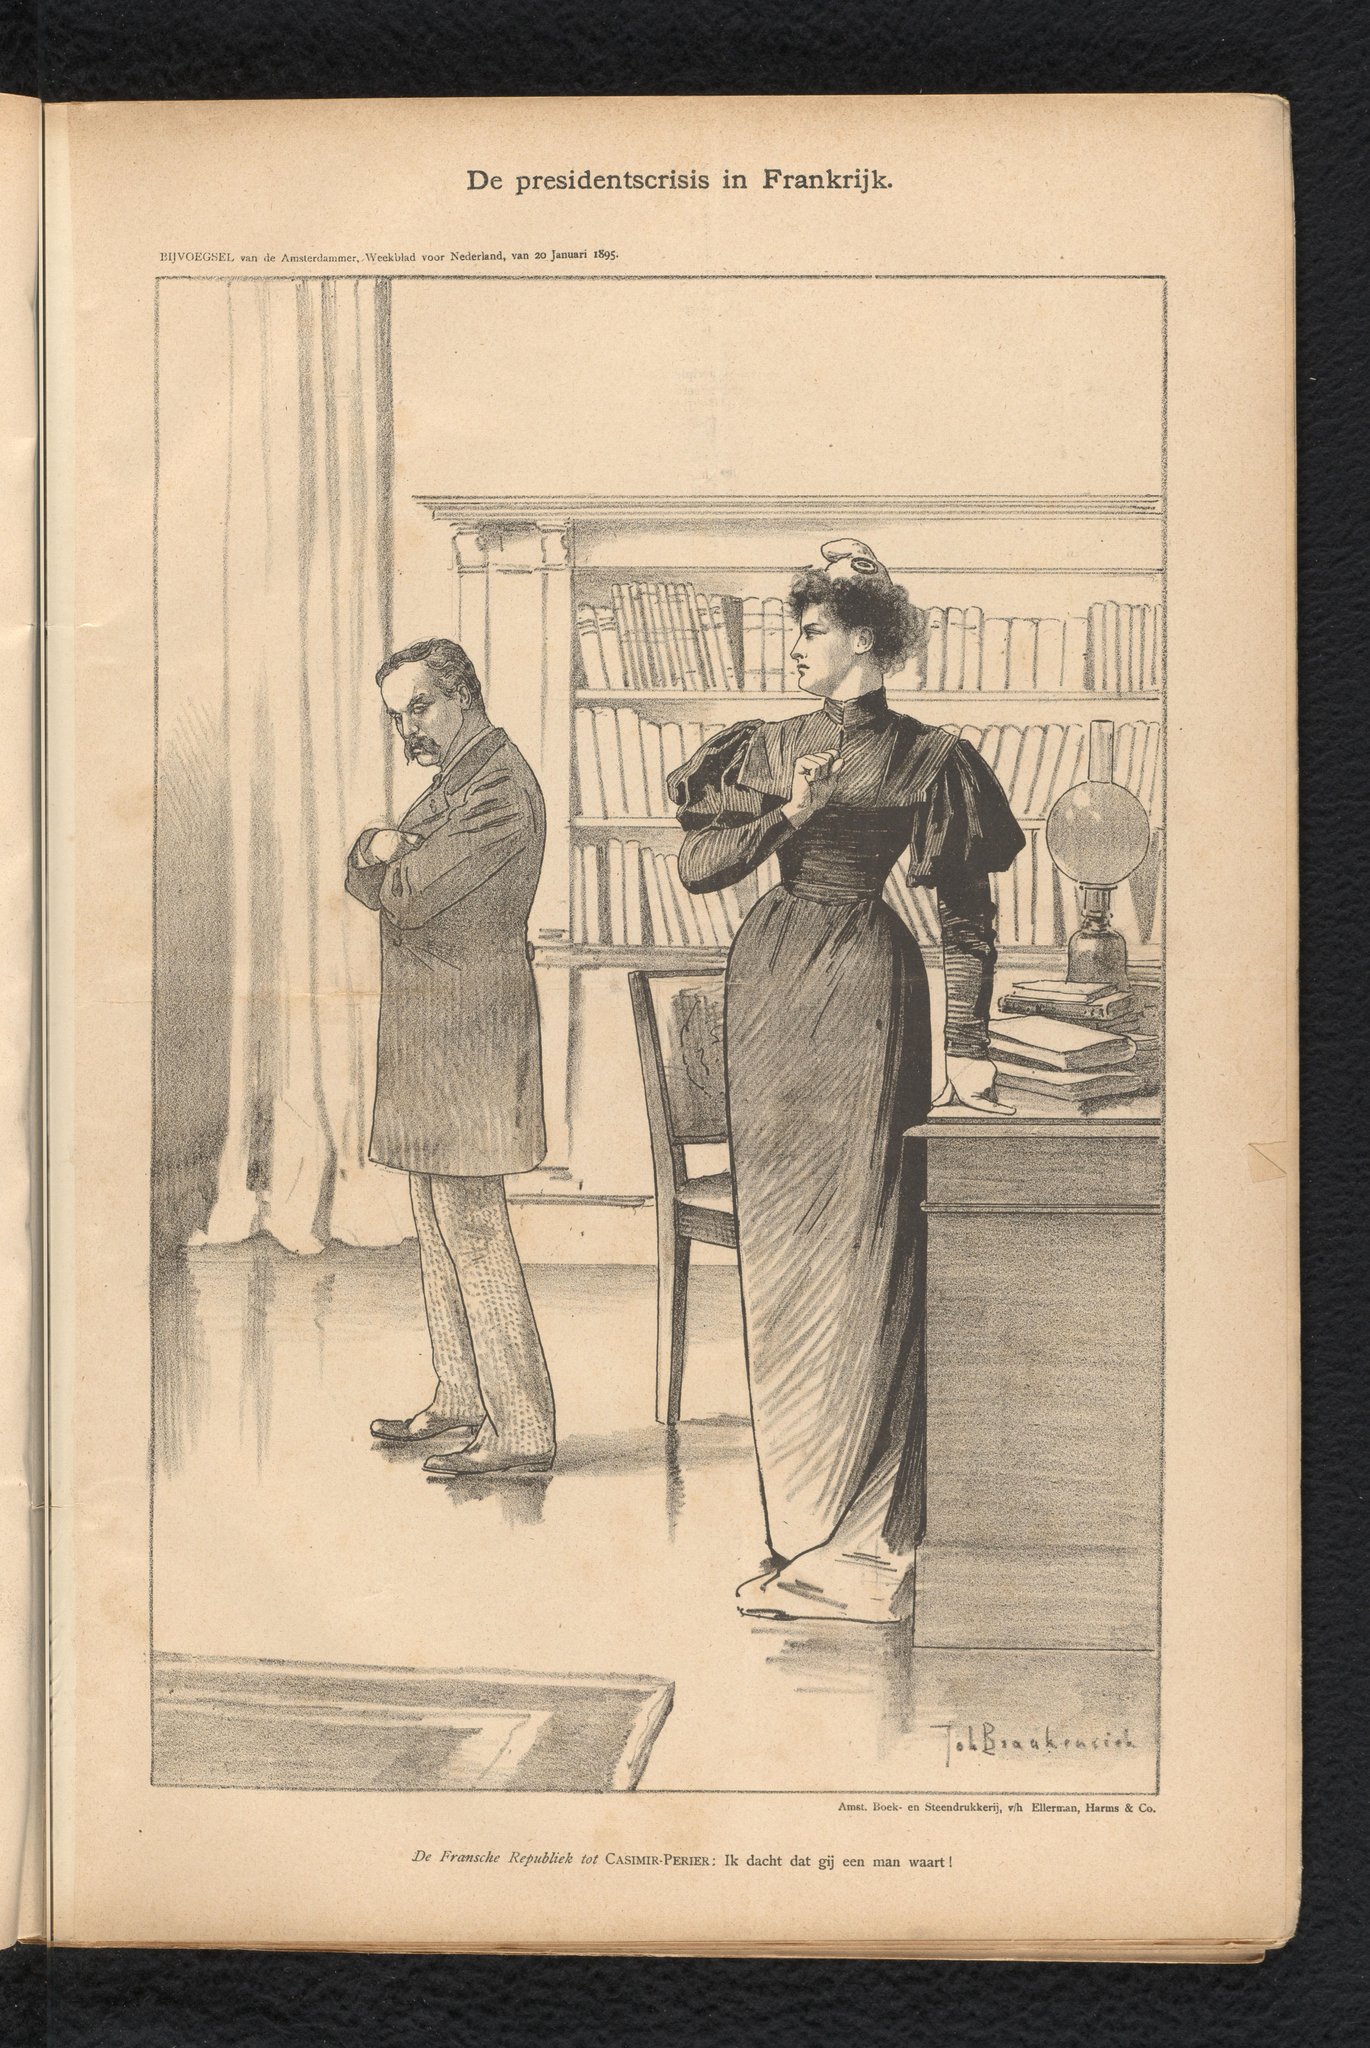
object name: cartoon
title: De presidentscrisis in Frankrijk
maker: johan braakensiek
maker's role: draughtsman, print maker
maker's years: 1858-1940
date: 1895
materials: paper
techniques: lithograph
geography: amsterdam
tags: personifications of countries, nations, states, districts, etc., president ~ head of republic, political caricatures and satires, france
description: Marianne (Frankrijk) is teleurgesteld in de Franse president Jean Casimir-Perier, die op 14 januari 1895 ontslag nam als president.